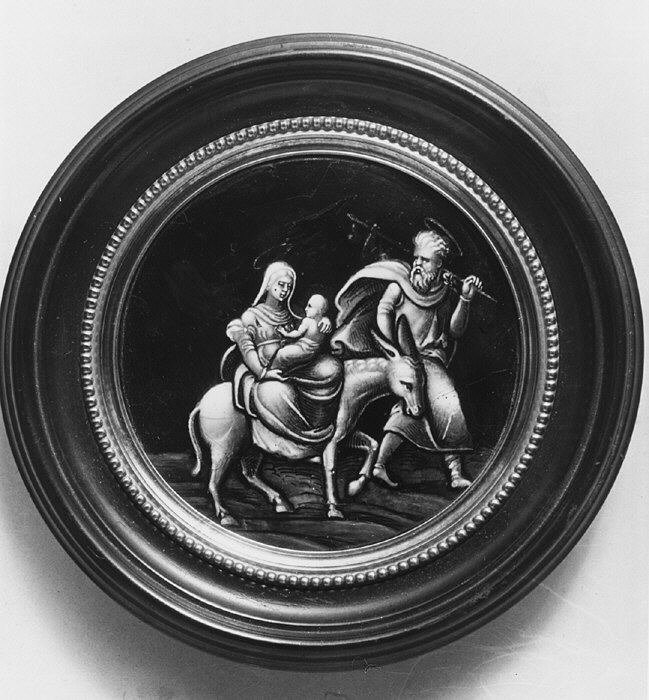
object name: medallion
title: The Flight into Egypt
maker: pierre reymond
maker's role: enameler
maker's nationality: french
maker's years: 1513-1590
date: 1551-1575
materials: copper, enamel, gilt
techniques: painting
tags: infants,men,women,donkeys